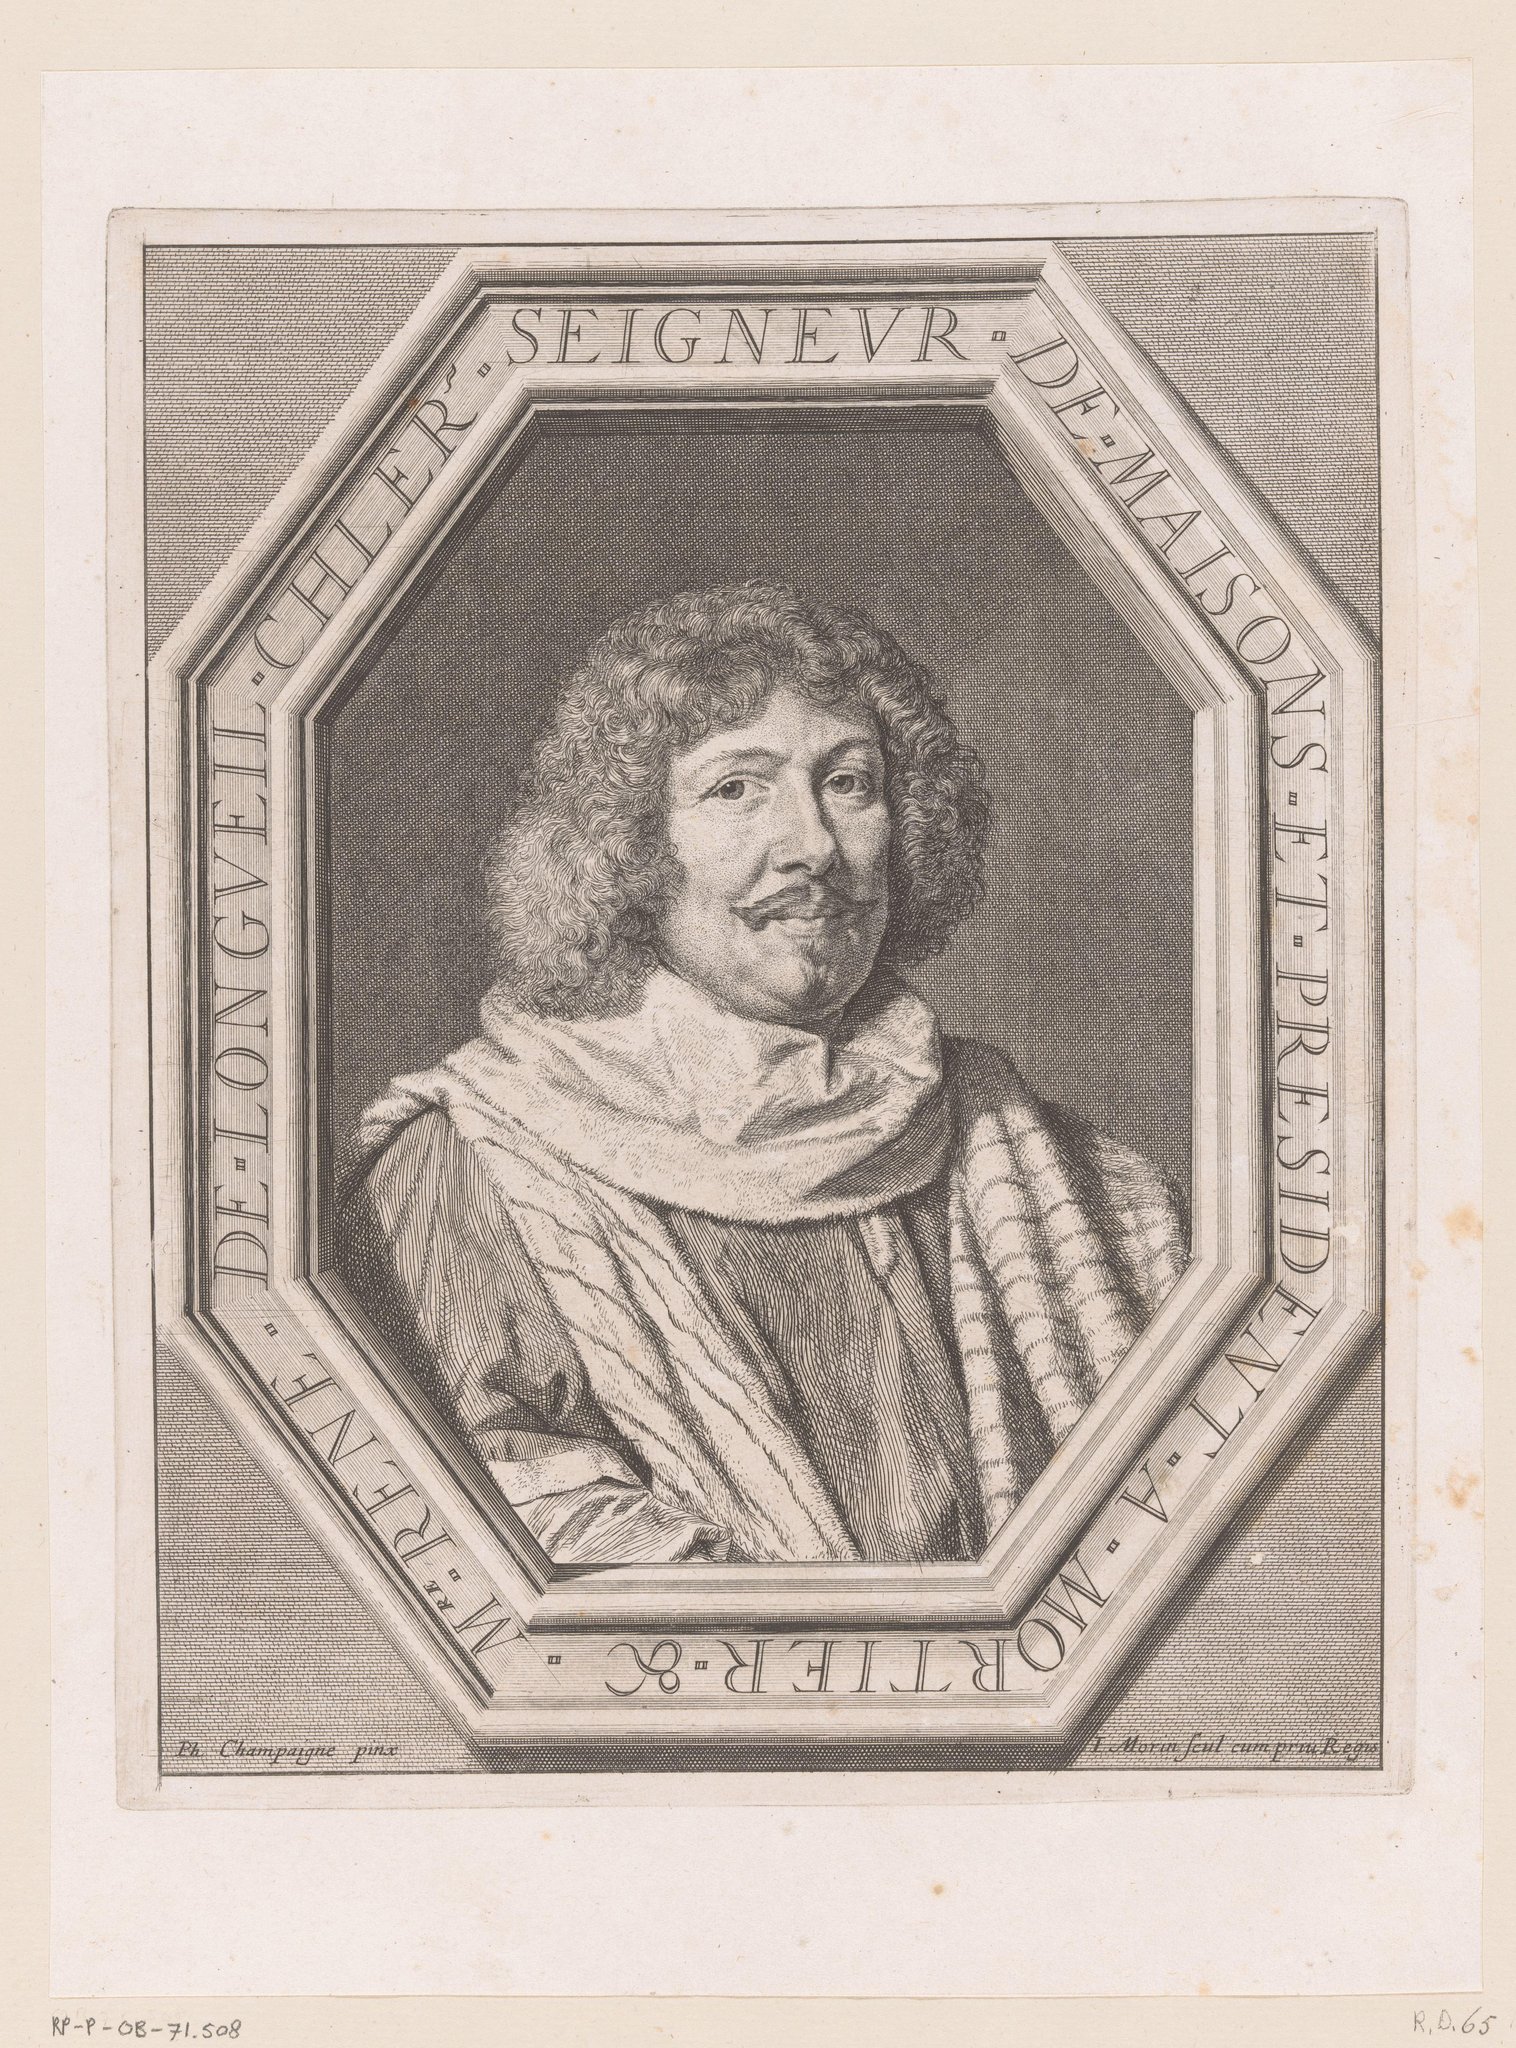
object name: print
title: Portret van René de Longueil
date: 1640-1650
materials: paper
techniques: etching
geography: france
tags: rené de longueil, historical persons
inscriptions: collector's mark: Lugt 2228